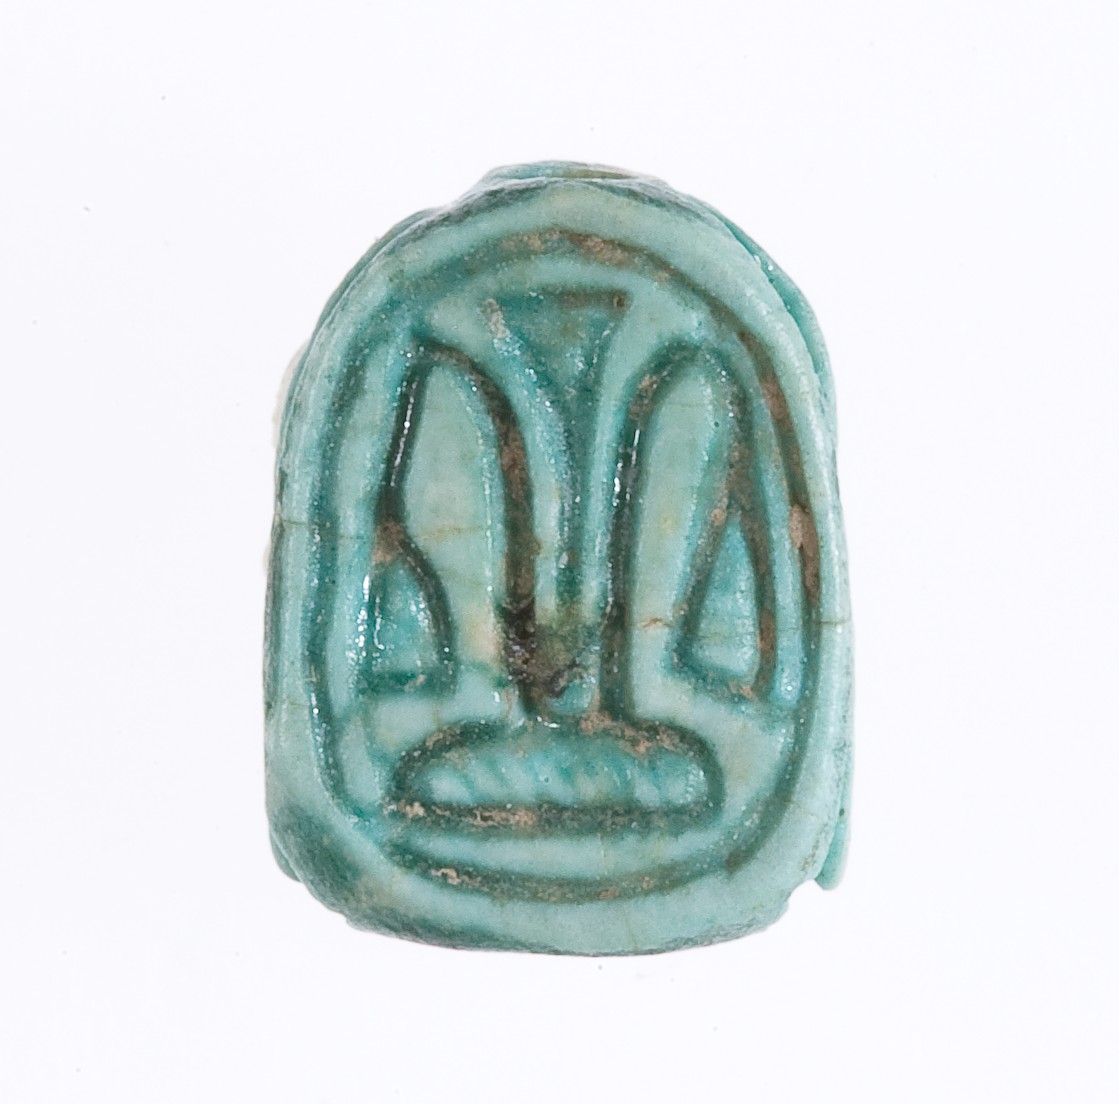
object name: seal, fish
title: Seal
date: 1550-1295 BCE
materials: stone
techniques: glazing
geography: egypt